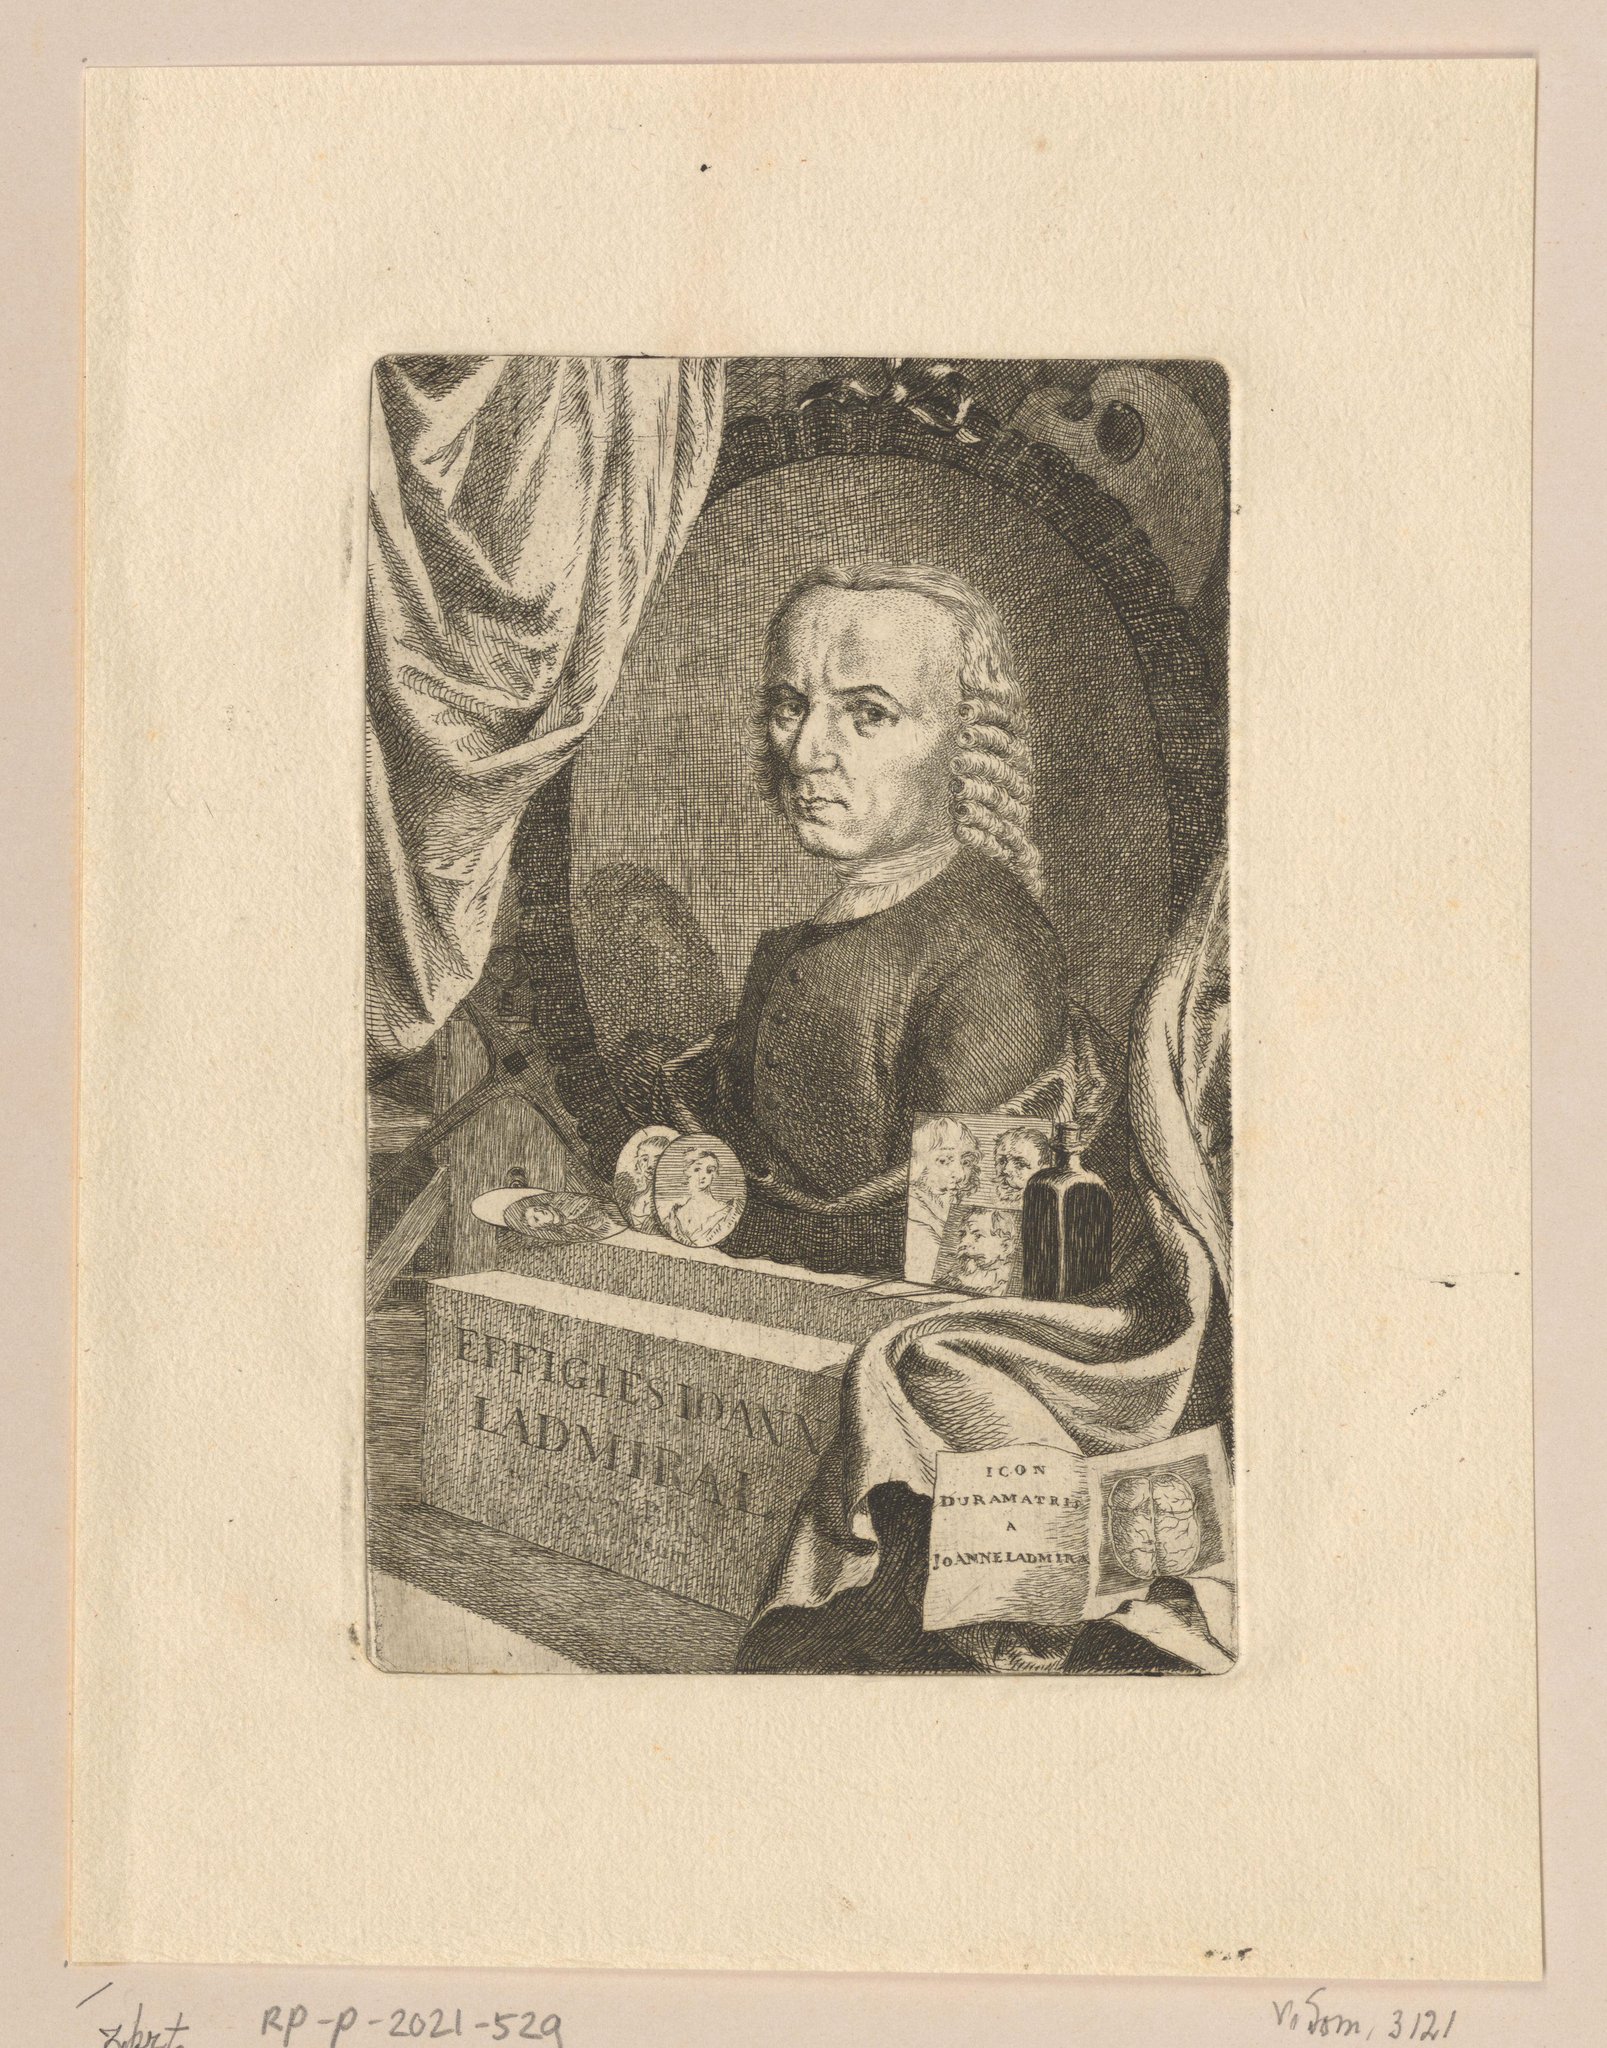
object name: print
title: Zelfportret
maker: jan l admiral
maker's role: draughtsman, print maker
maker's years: 1699-1773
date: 1764-1773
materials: paper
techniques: etching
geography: amsterdam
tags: amsterdam, draughtsman, jan l' admiral, ornament ~ medallion, historical persons, book - mm - book open, tools, implements of graphic artist, palette, portrait, self-portrait of graphic artist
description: Zelfportret van de kunstenaar Jan l'Admiral, omgeven door kleine portretten en een etsplaat met drie koppen uit Karel van Manders 'Het leven der doorluchtige Nederlandsche schilders (...)', 1764, dl. 2. Rechts ligt op de voorgrond een van zijn boeken 'Icon durae matris' (1738), met illustratie.